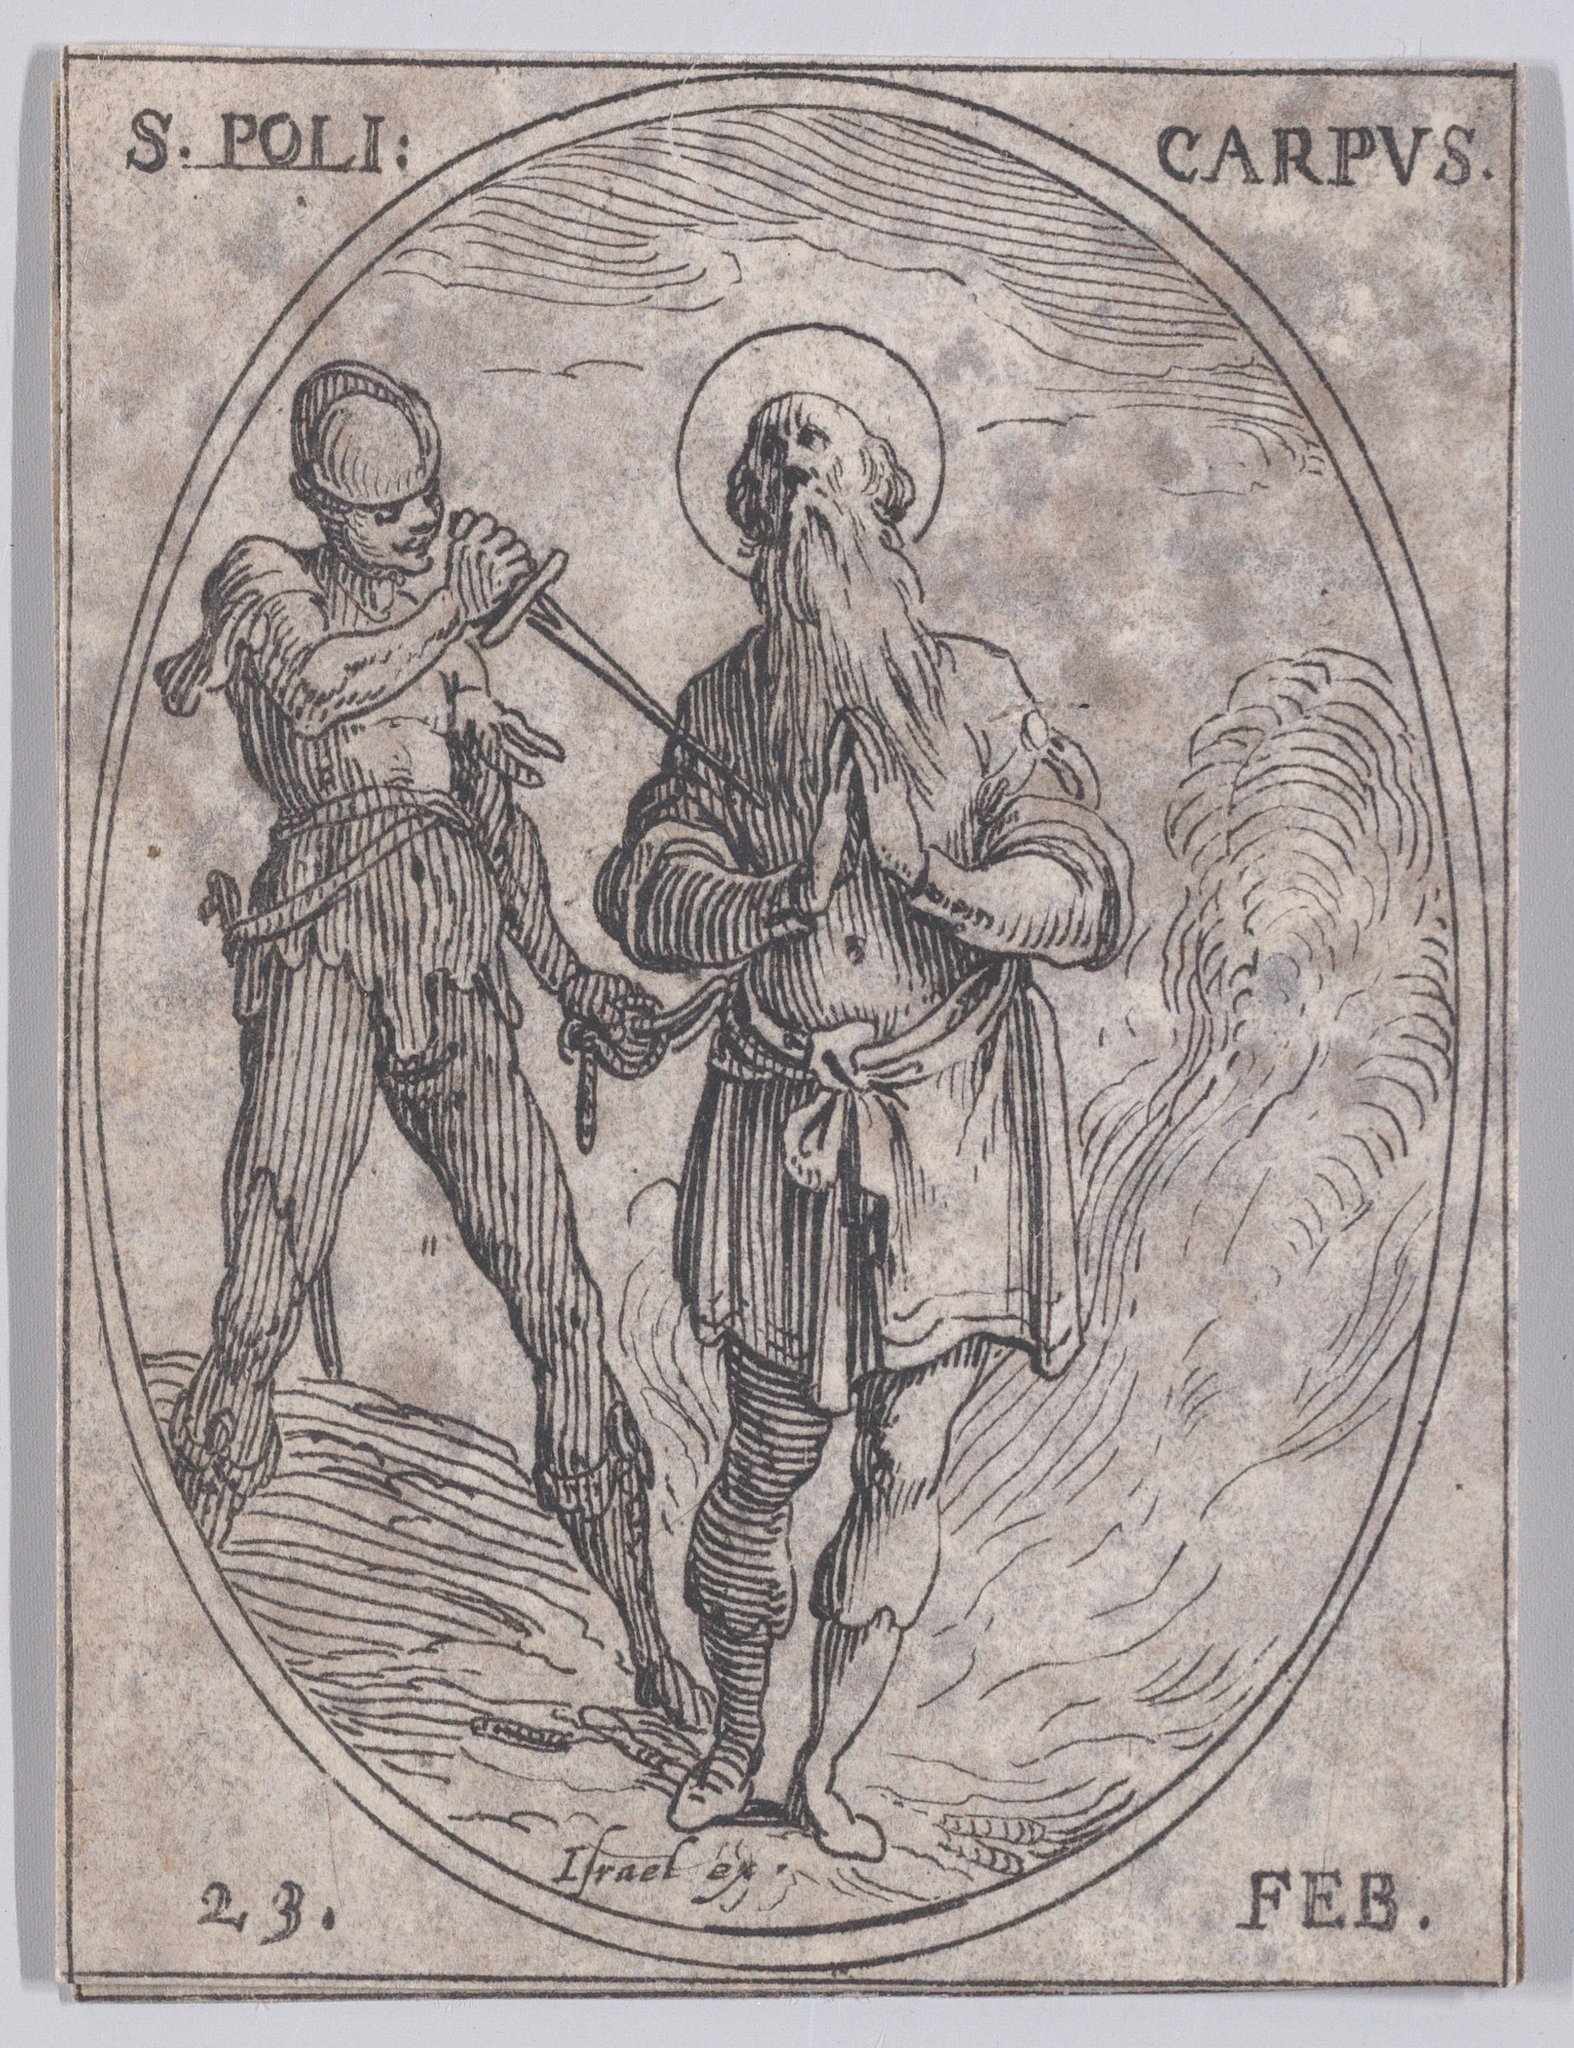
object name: print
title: S. Joseph d'Arimathie (St. Joseph of Arimathea), February 22nd, from "Les Images De Tous Les Saincts et Saintes de L'Année" (Images of All of the Saints and Religious Events of the Year)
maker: jacques callot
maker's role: artist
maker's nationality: french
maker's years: 1592-1635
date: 1636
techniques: etching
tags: men,saints